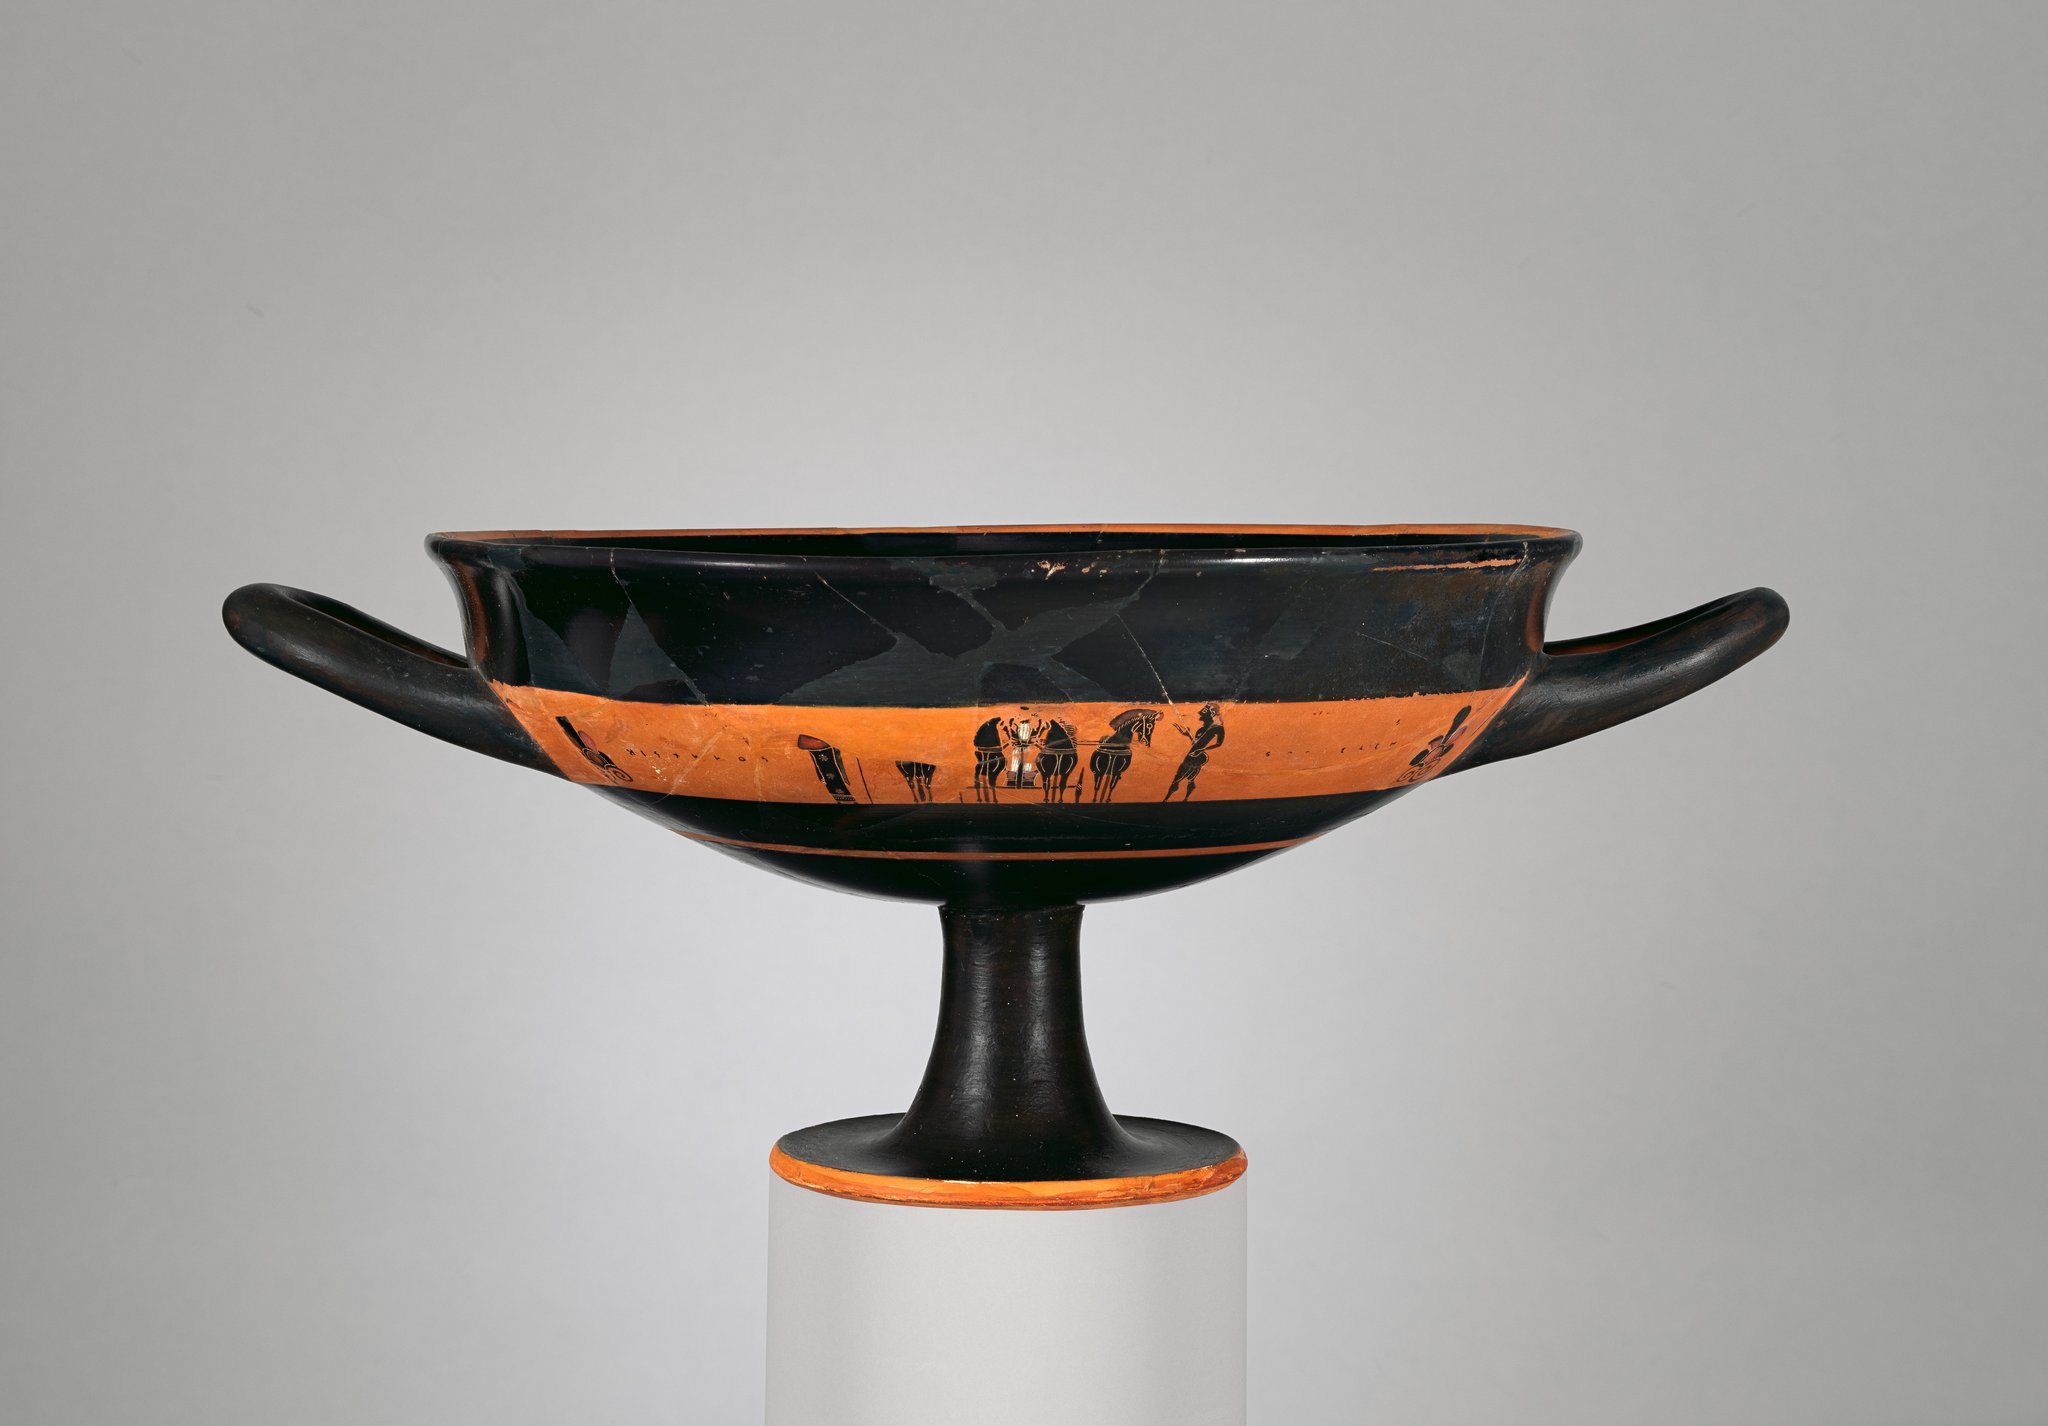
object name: kylix, band cup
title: Terracotta kylix: band-cup (drinking cup)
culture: greek, attic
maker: hischylos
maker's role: artist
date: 550-540 BCE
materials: terracotta